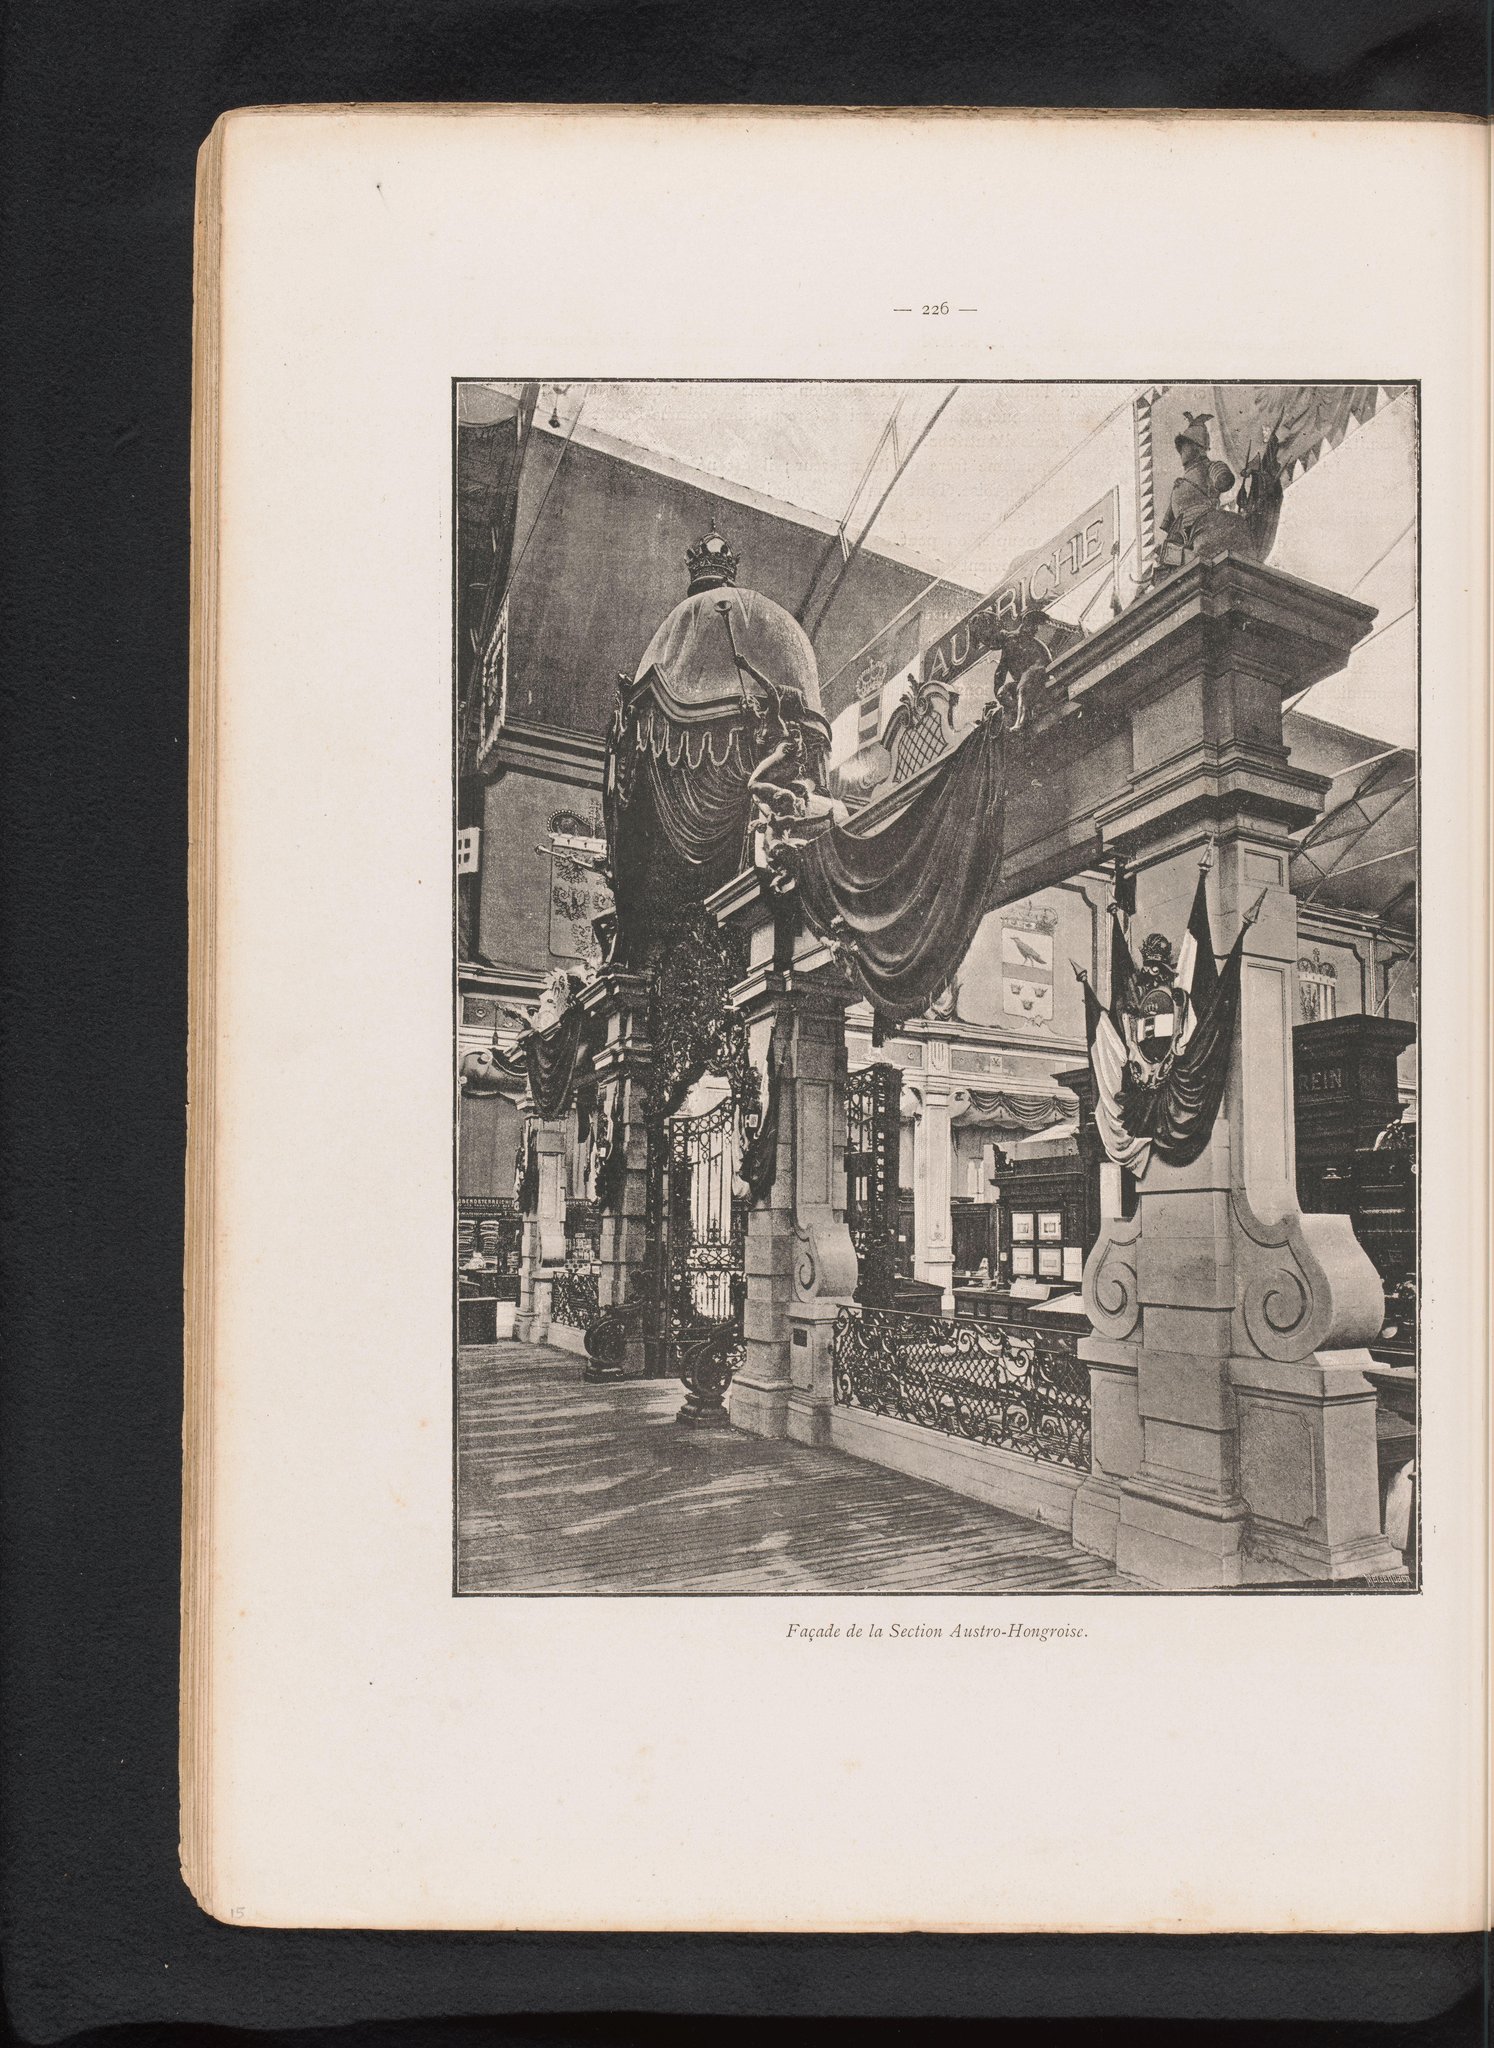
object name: page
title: Façade de la Section Austro-Hongroise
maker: Anonymous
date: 1880-1885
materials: paper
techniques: autotype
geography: antwerp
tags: world fair, world exhibition, antwerp